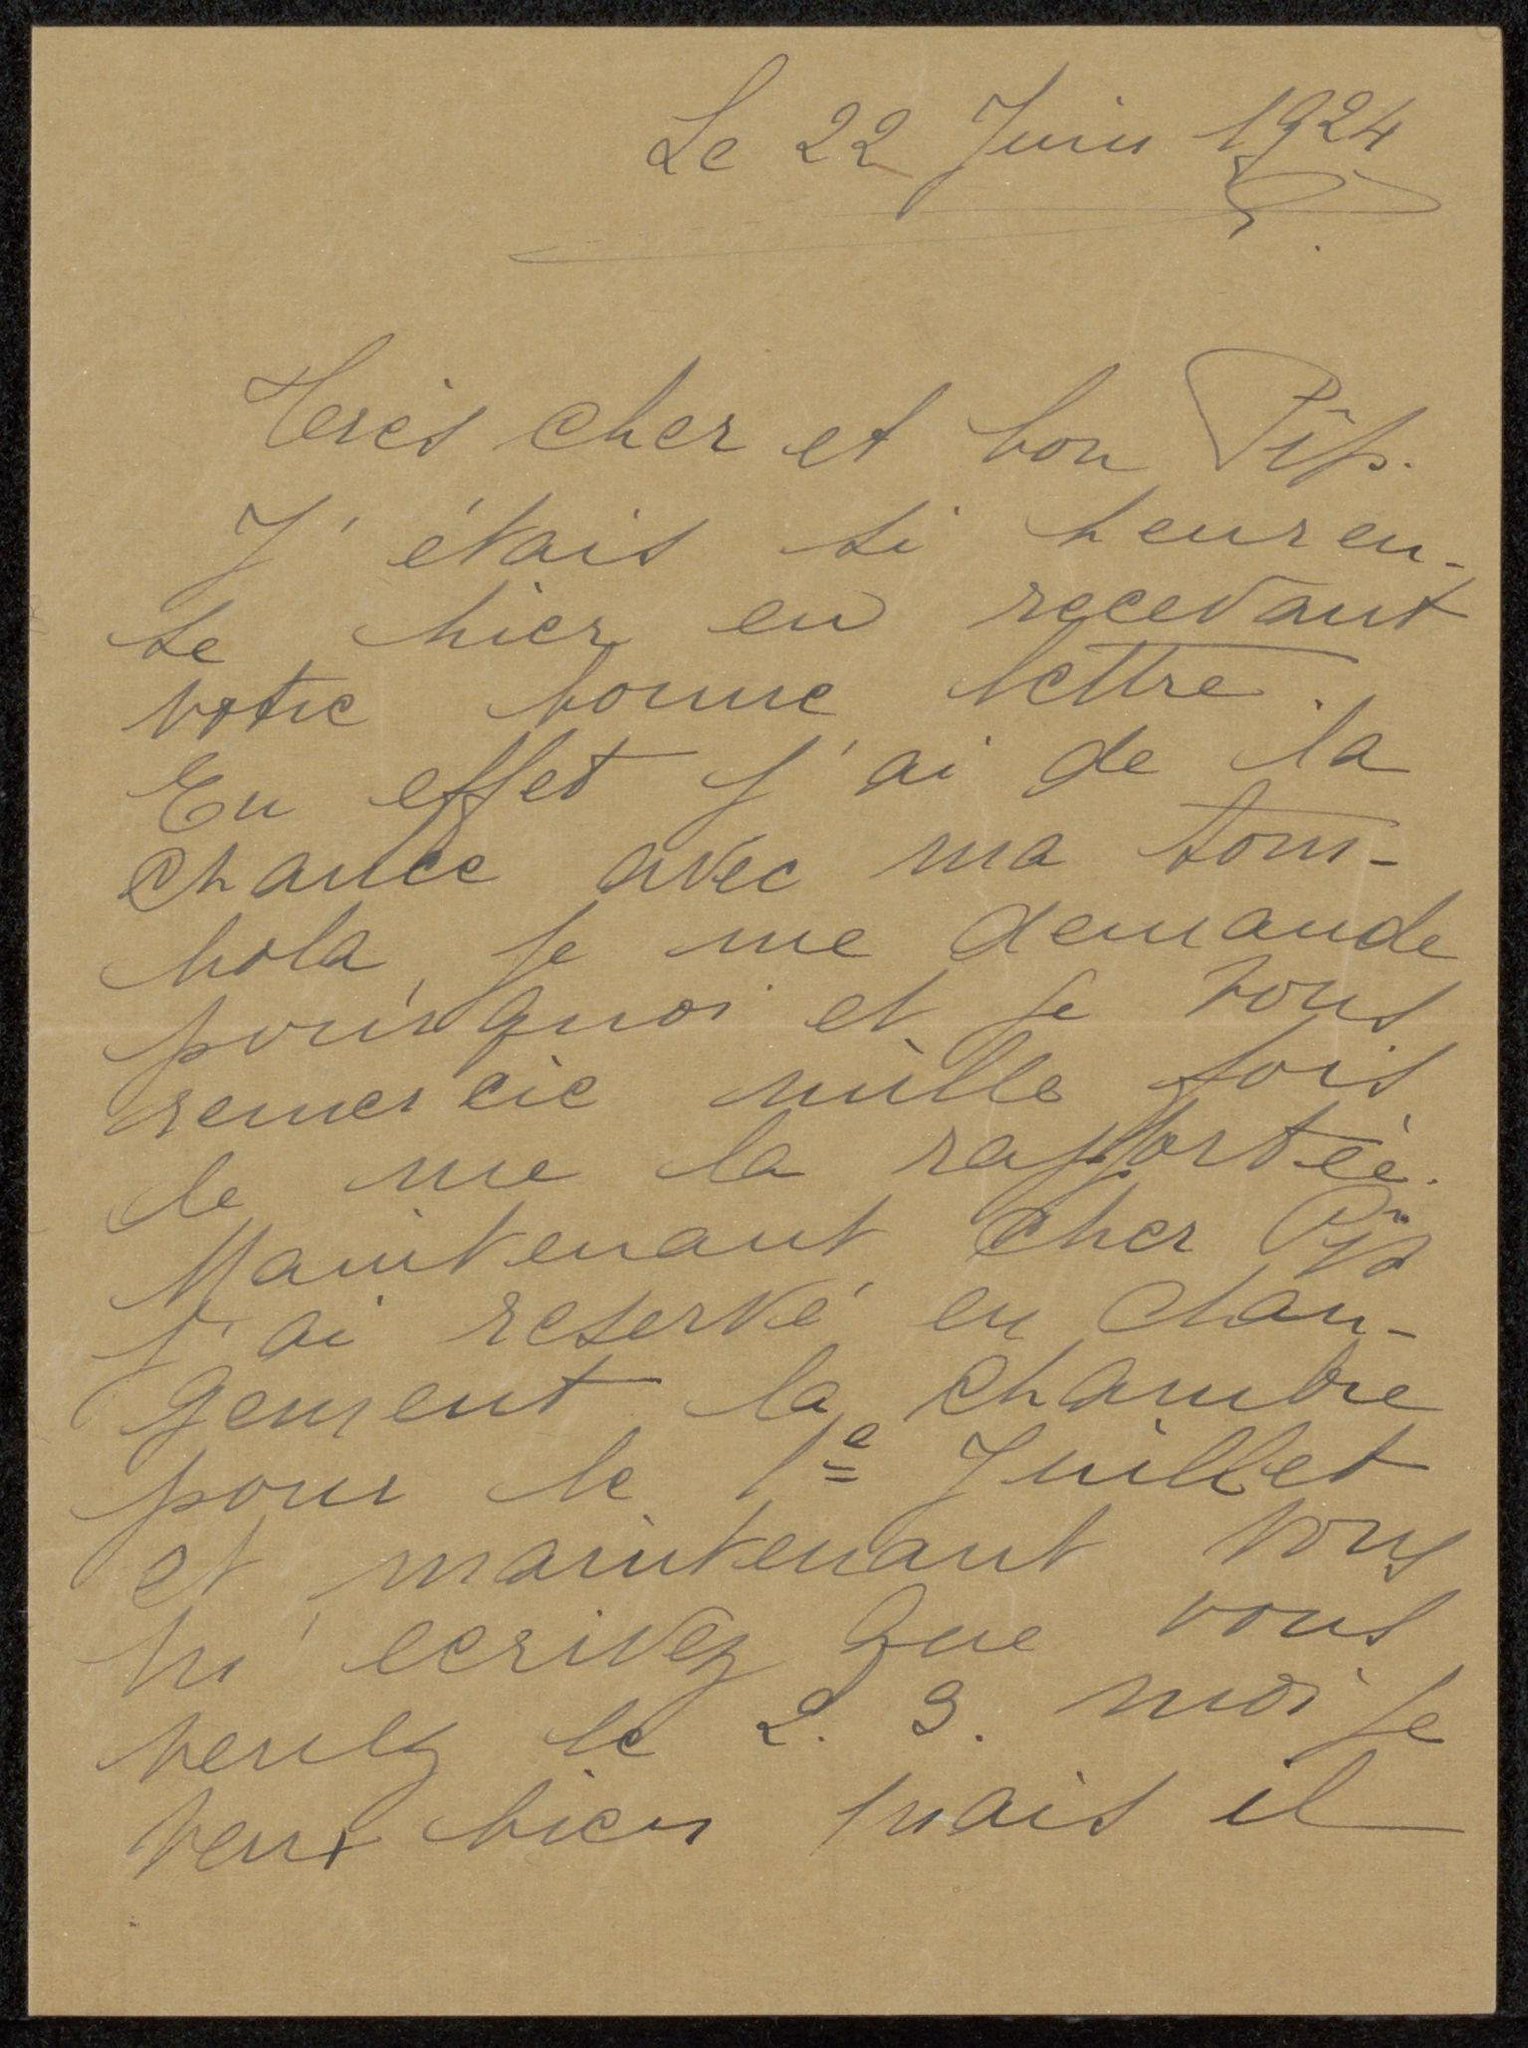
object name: letter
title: Brief aan Philip Zilcken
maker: rose imel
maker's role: draughtsman, painter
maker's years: 1901-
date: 1924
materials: ink, paper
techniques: pen, writing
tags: painter, draughtsman, philip zilcken, education, tuition of the artist (in general), paris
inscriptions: collector's mark: ‘RPK’